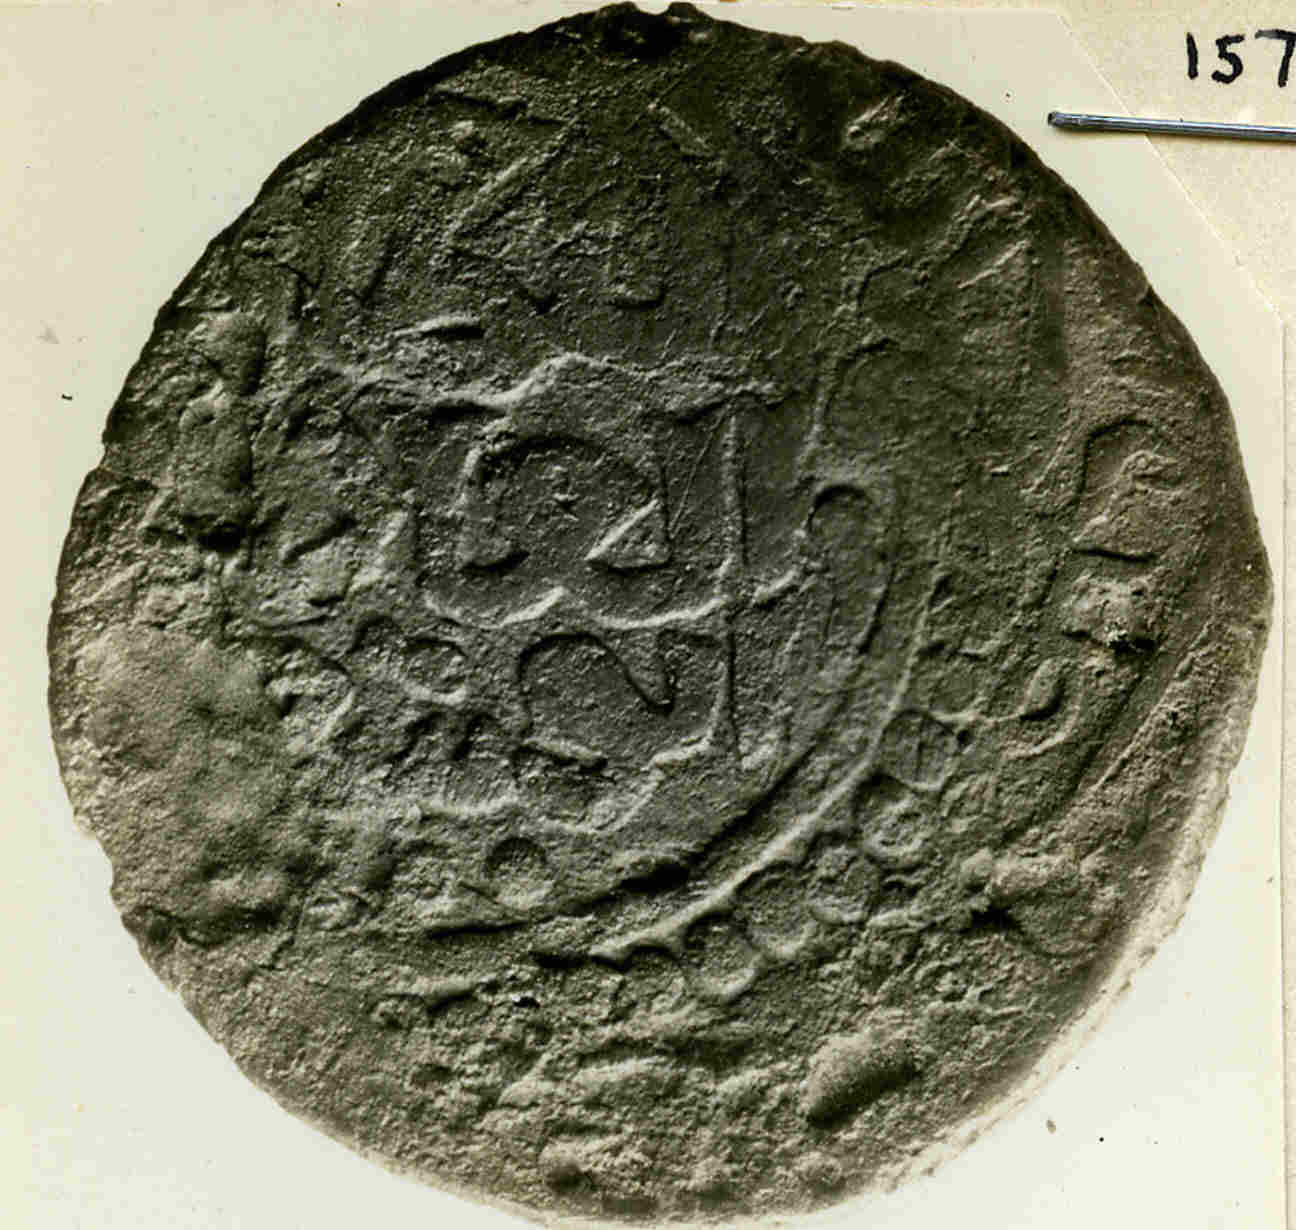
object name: coin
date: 1301-1400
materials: copper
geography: iran